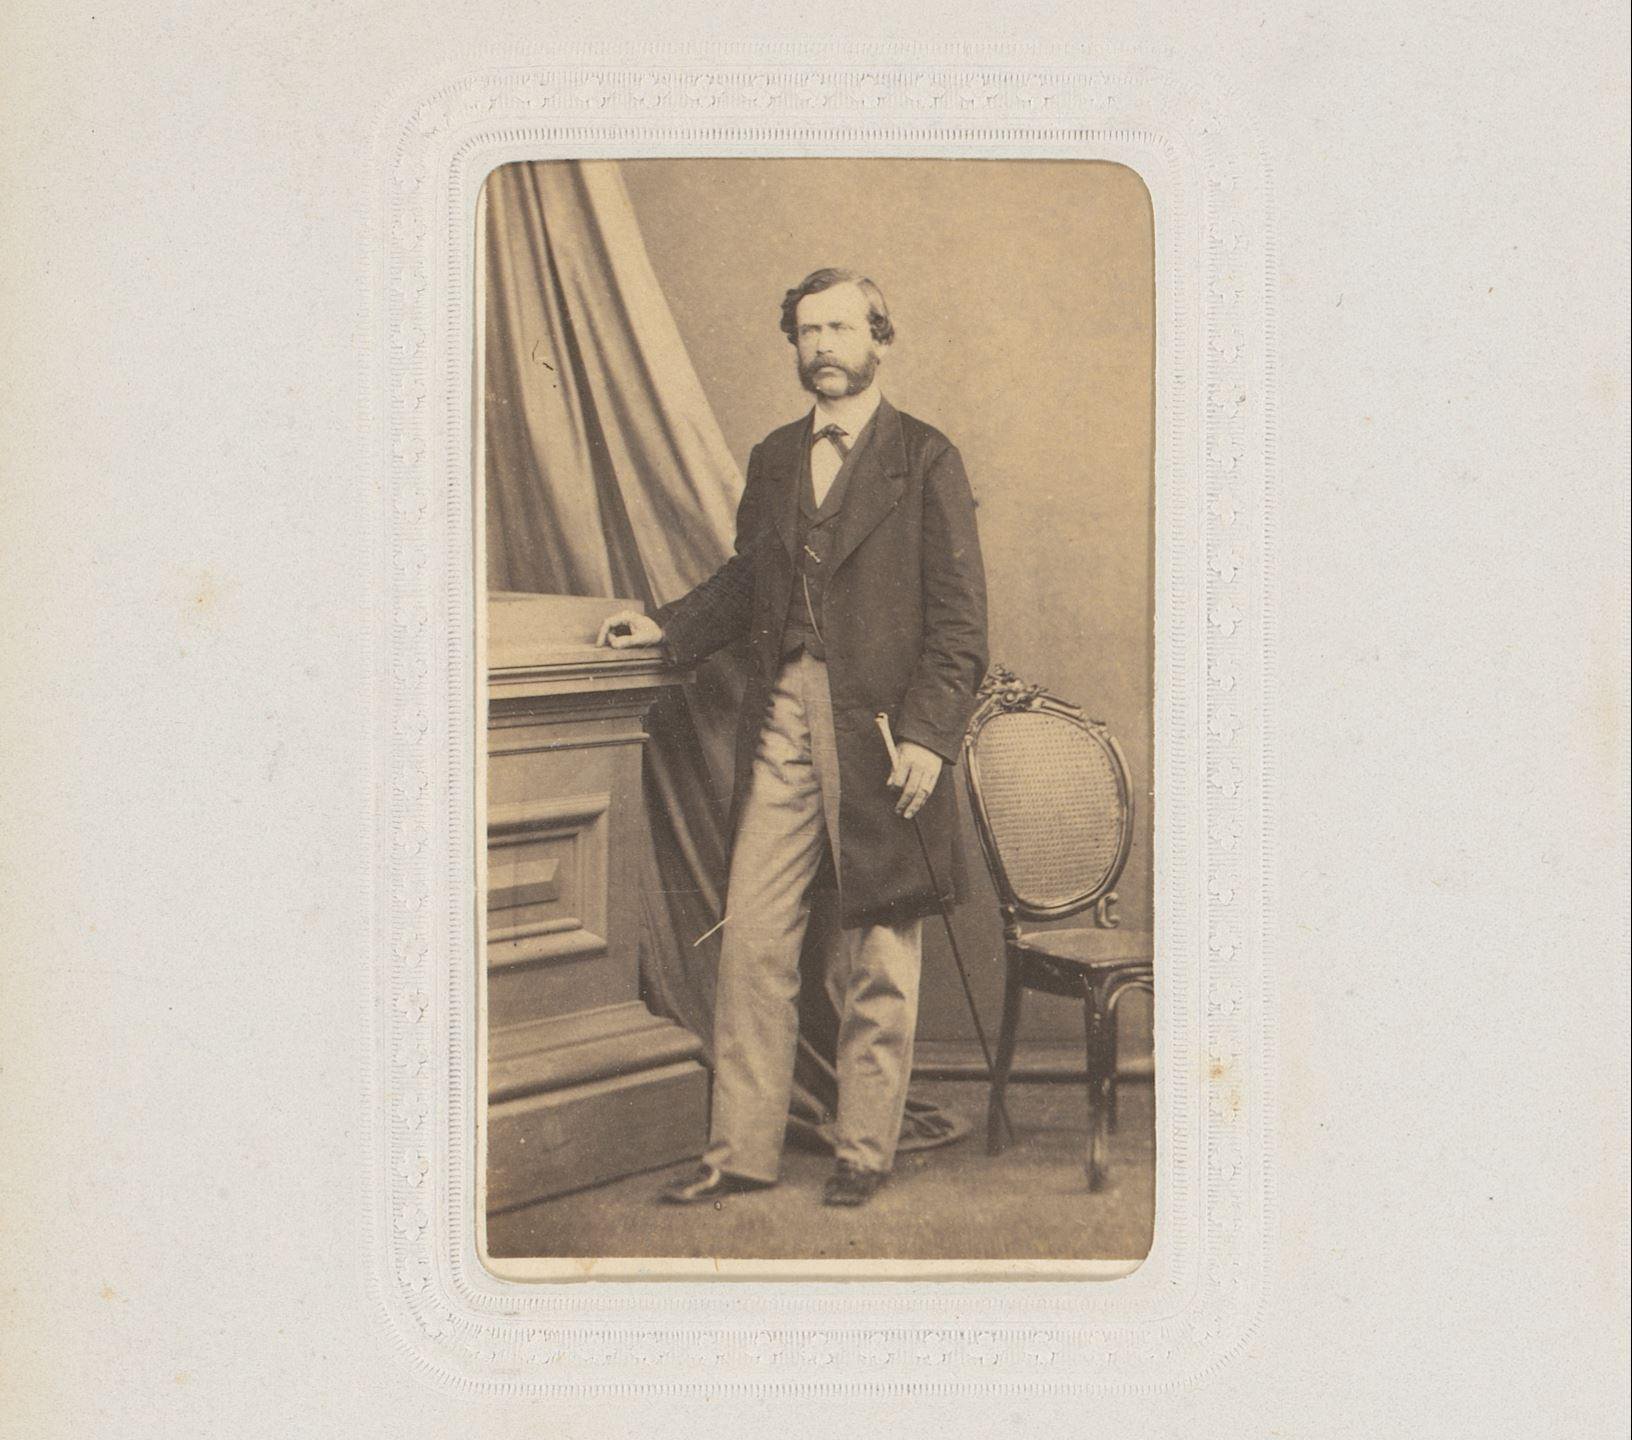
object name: photograph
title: Portret van een man met baard en wandelstok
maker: j.b. fernandez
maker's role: fotograaf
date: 1860-1890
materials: cardboard, photographic support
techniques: albumen print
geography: havana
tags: walking-stick, staff, historical persons, beard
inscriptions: inscription: ‘Fernandez/ 66/ O'Reilly/ Habana’